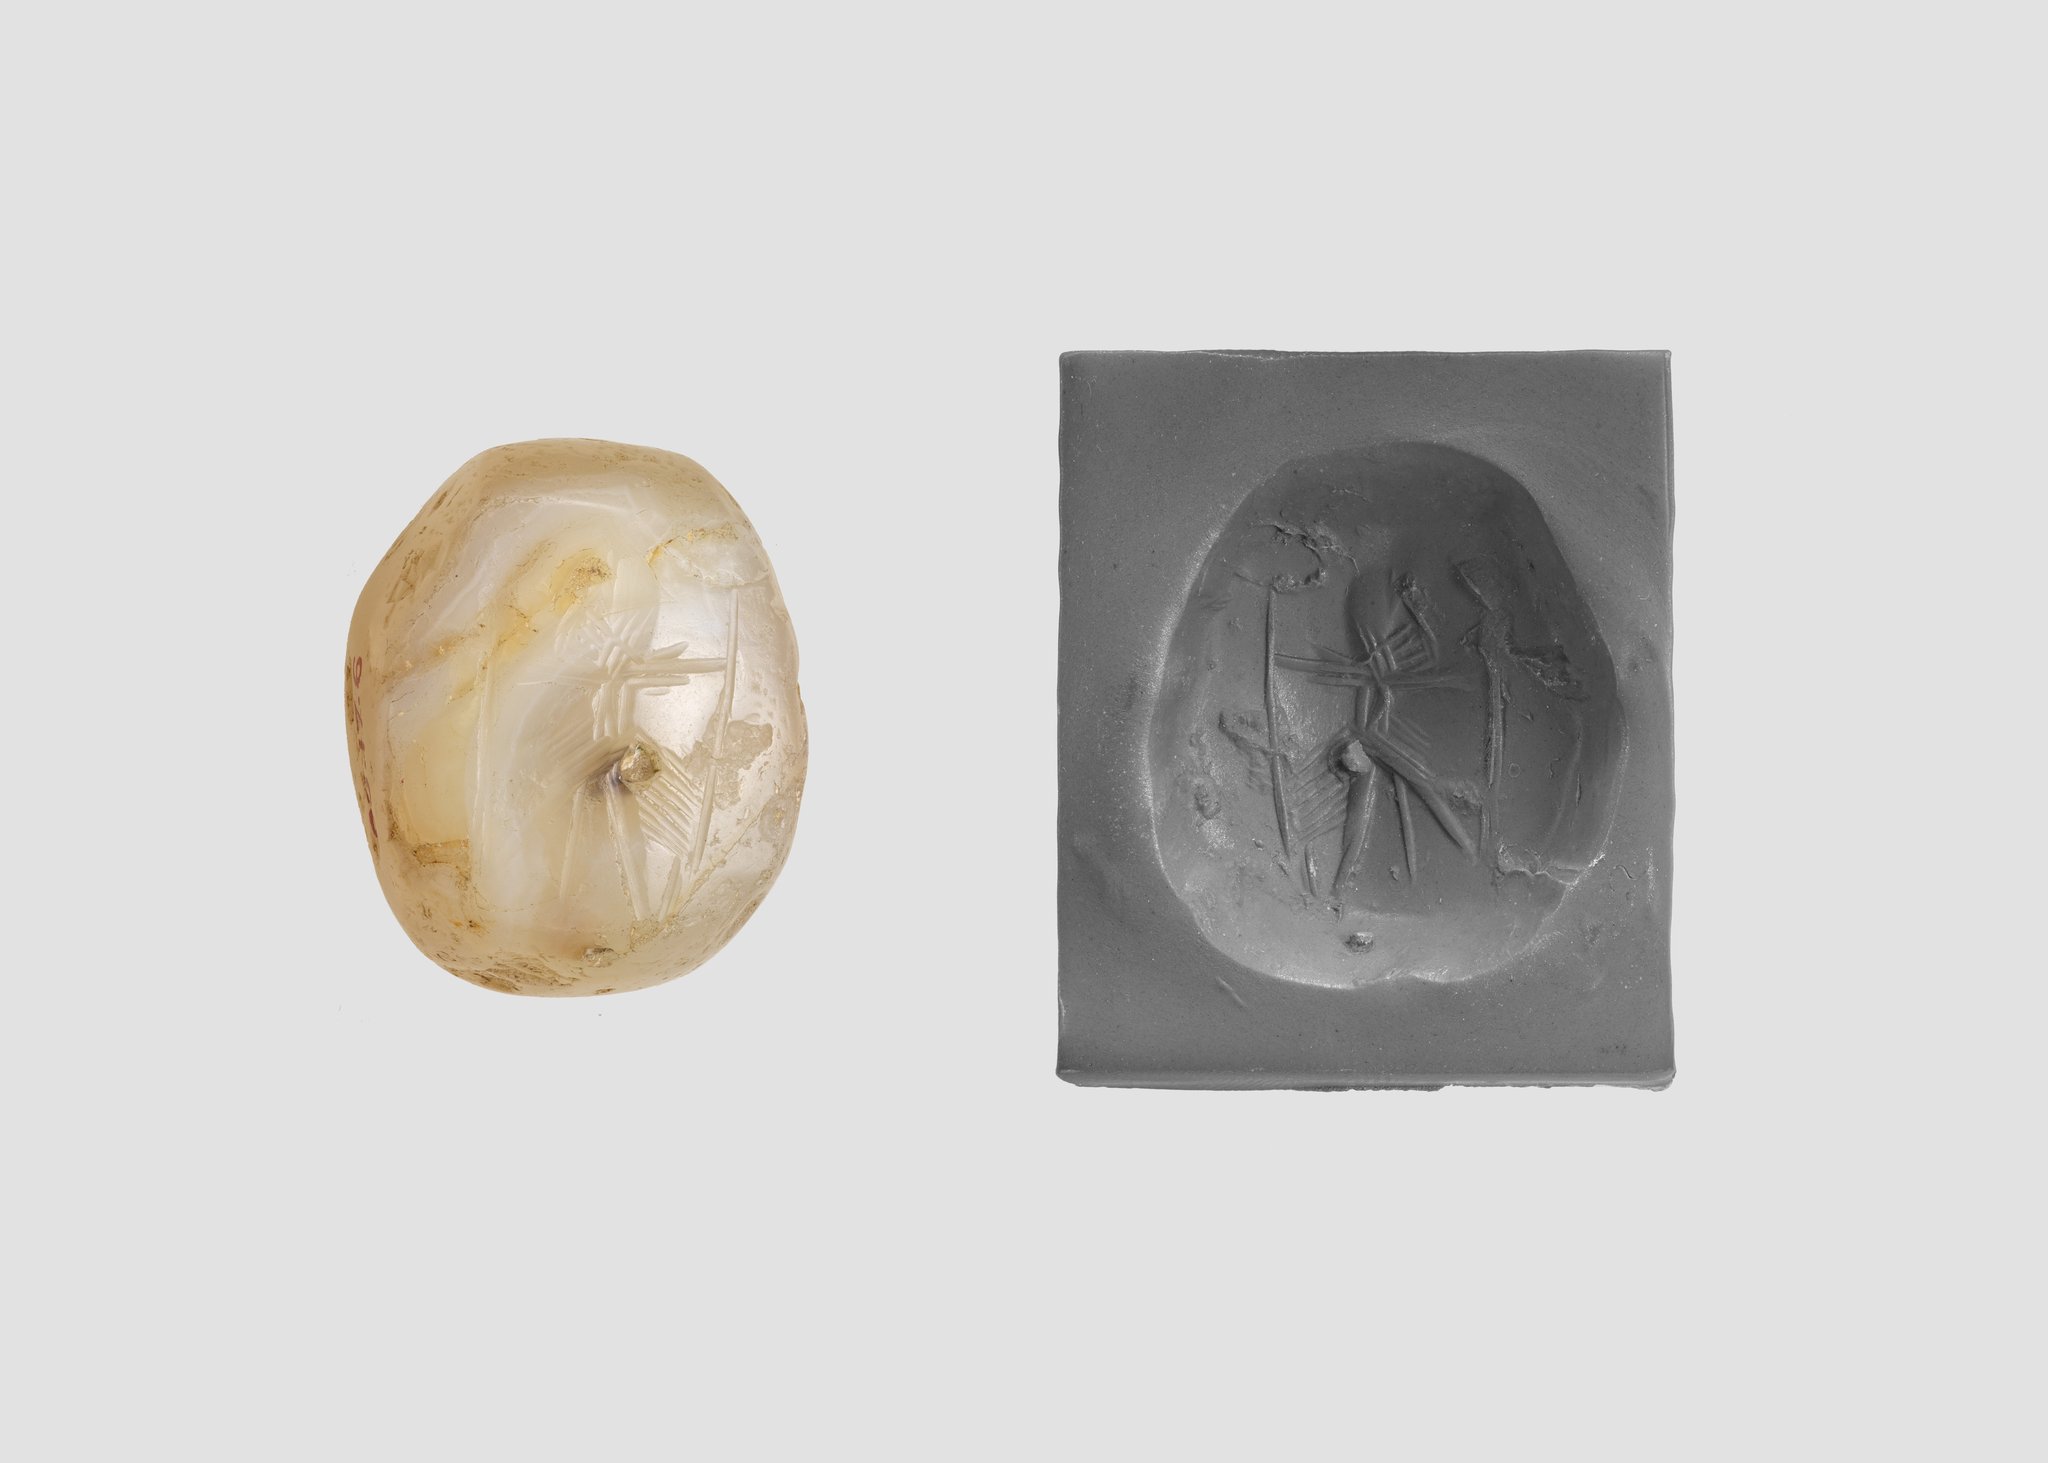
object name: stamp seal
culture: sasanian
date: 201-700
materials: stone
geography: iran or mesopotamia